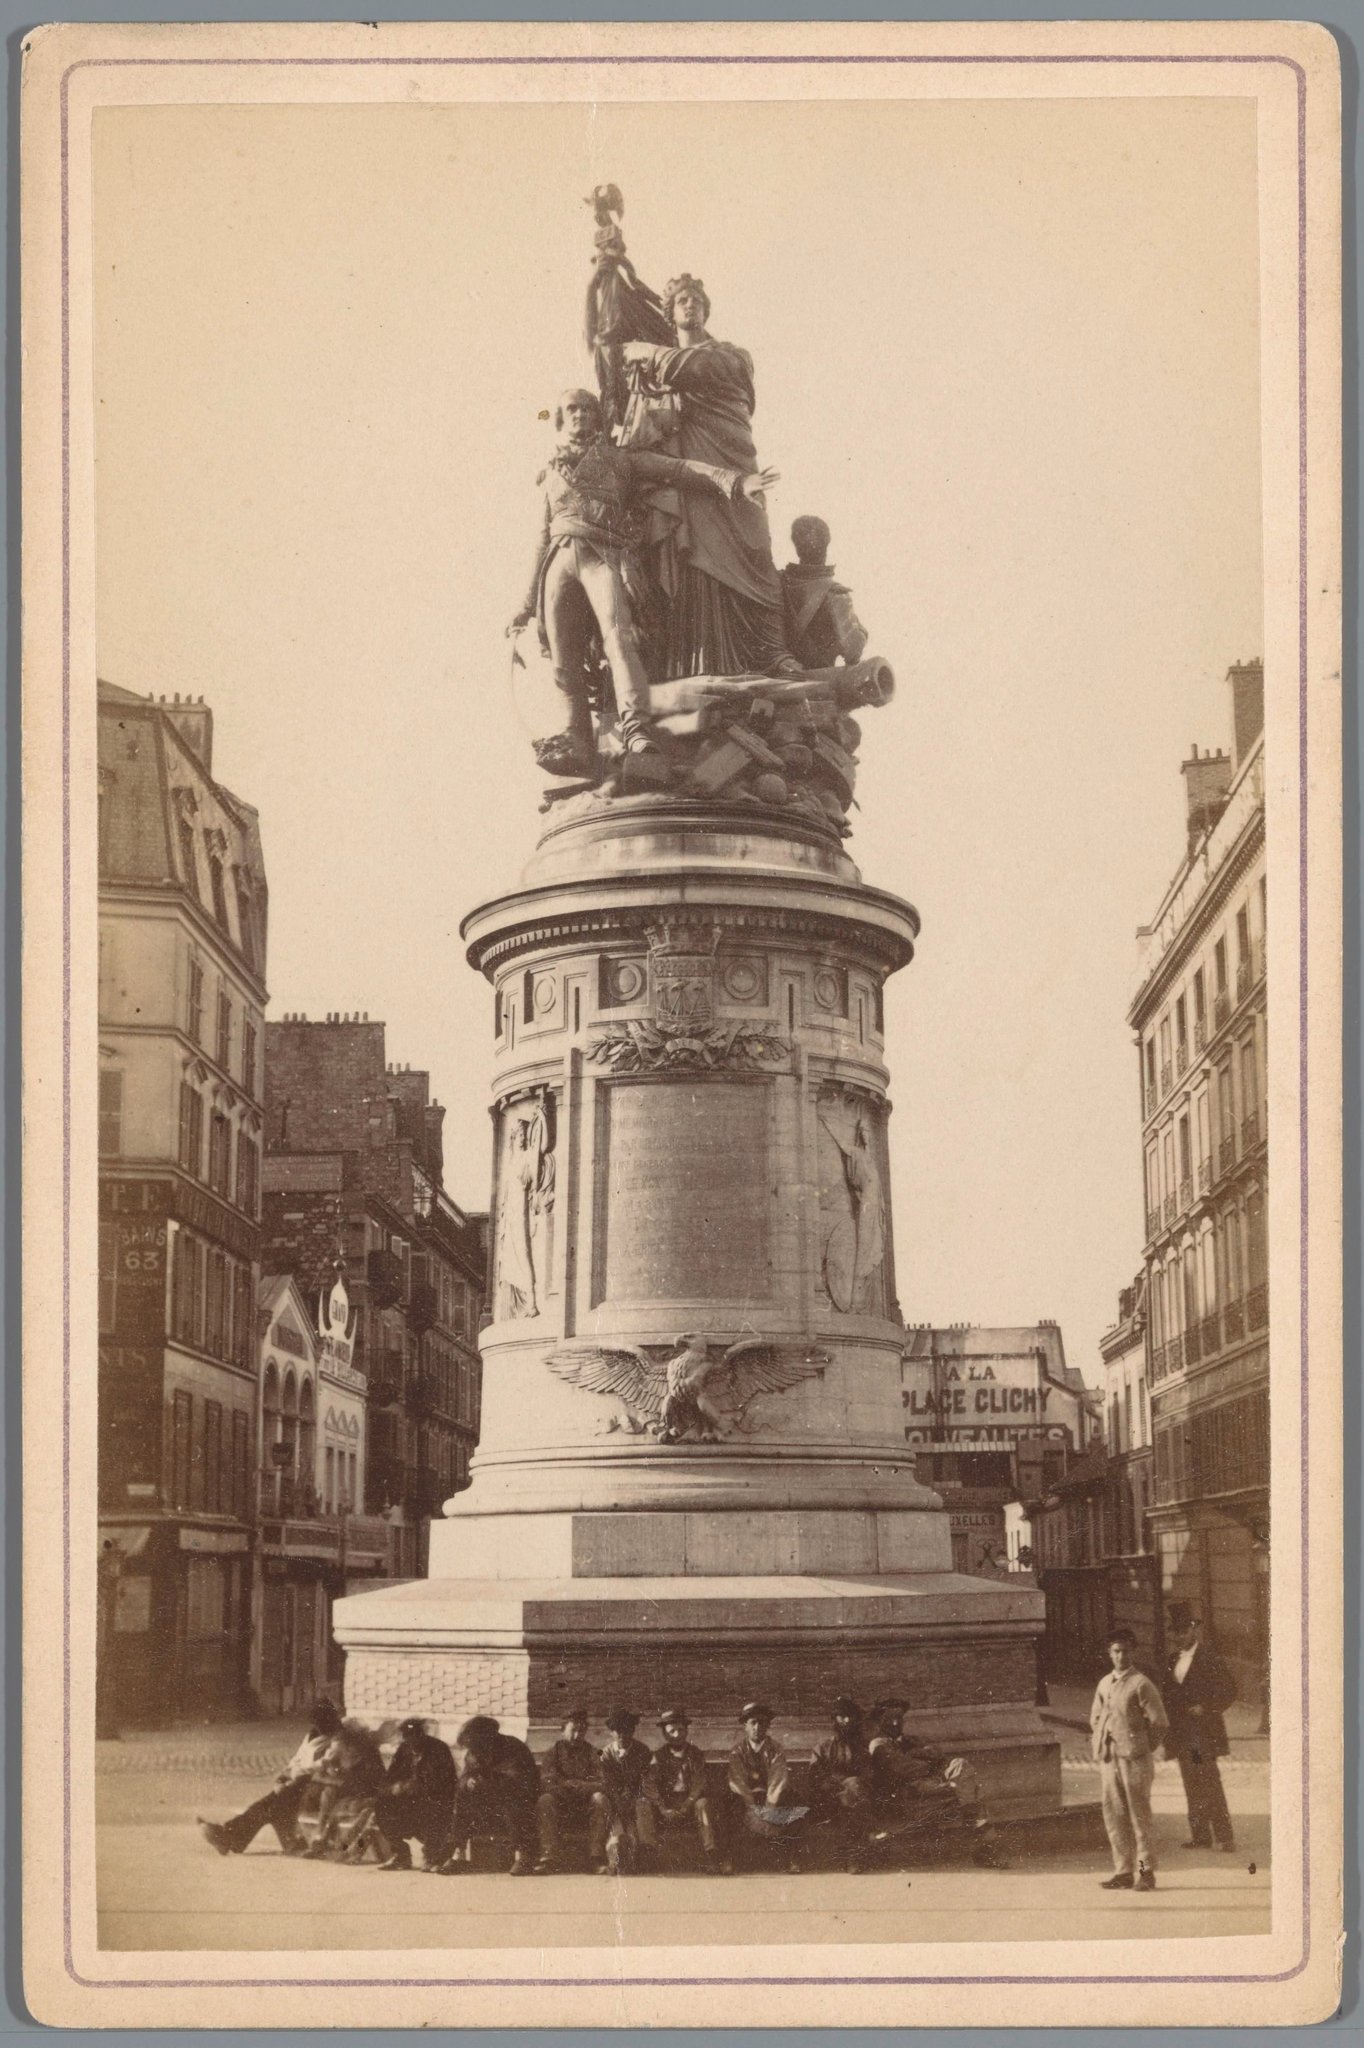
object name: cabinet photograph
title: Place Clychi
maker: Anonymous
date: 1870-1890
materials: cardboard, paper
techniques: albumen print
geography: paris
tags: monument, statue